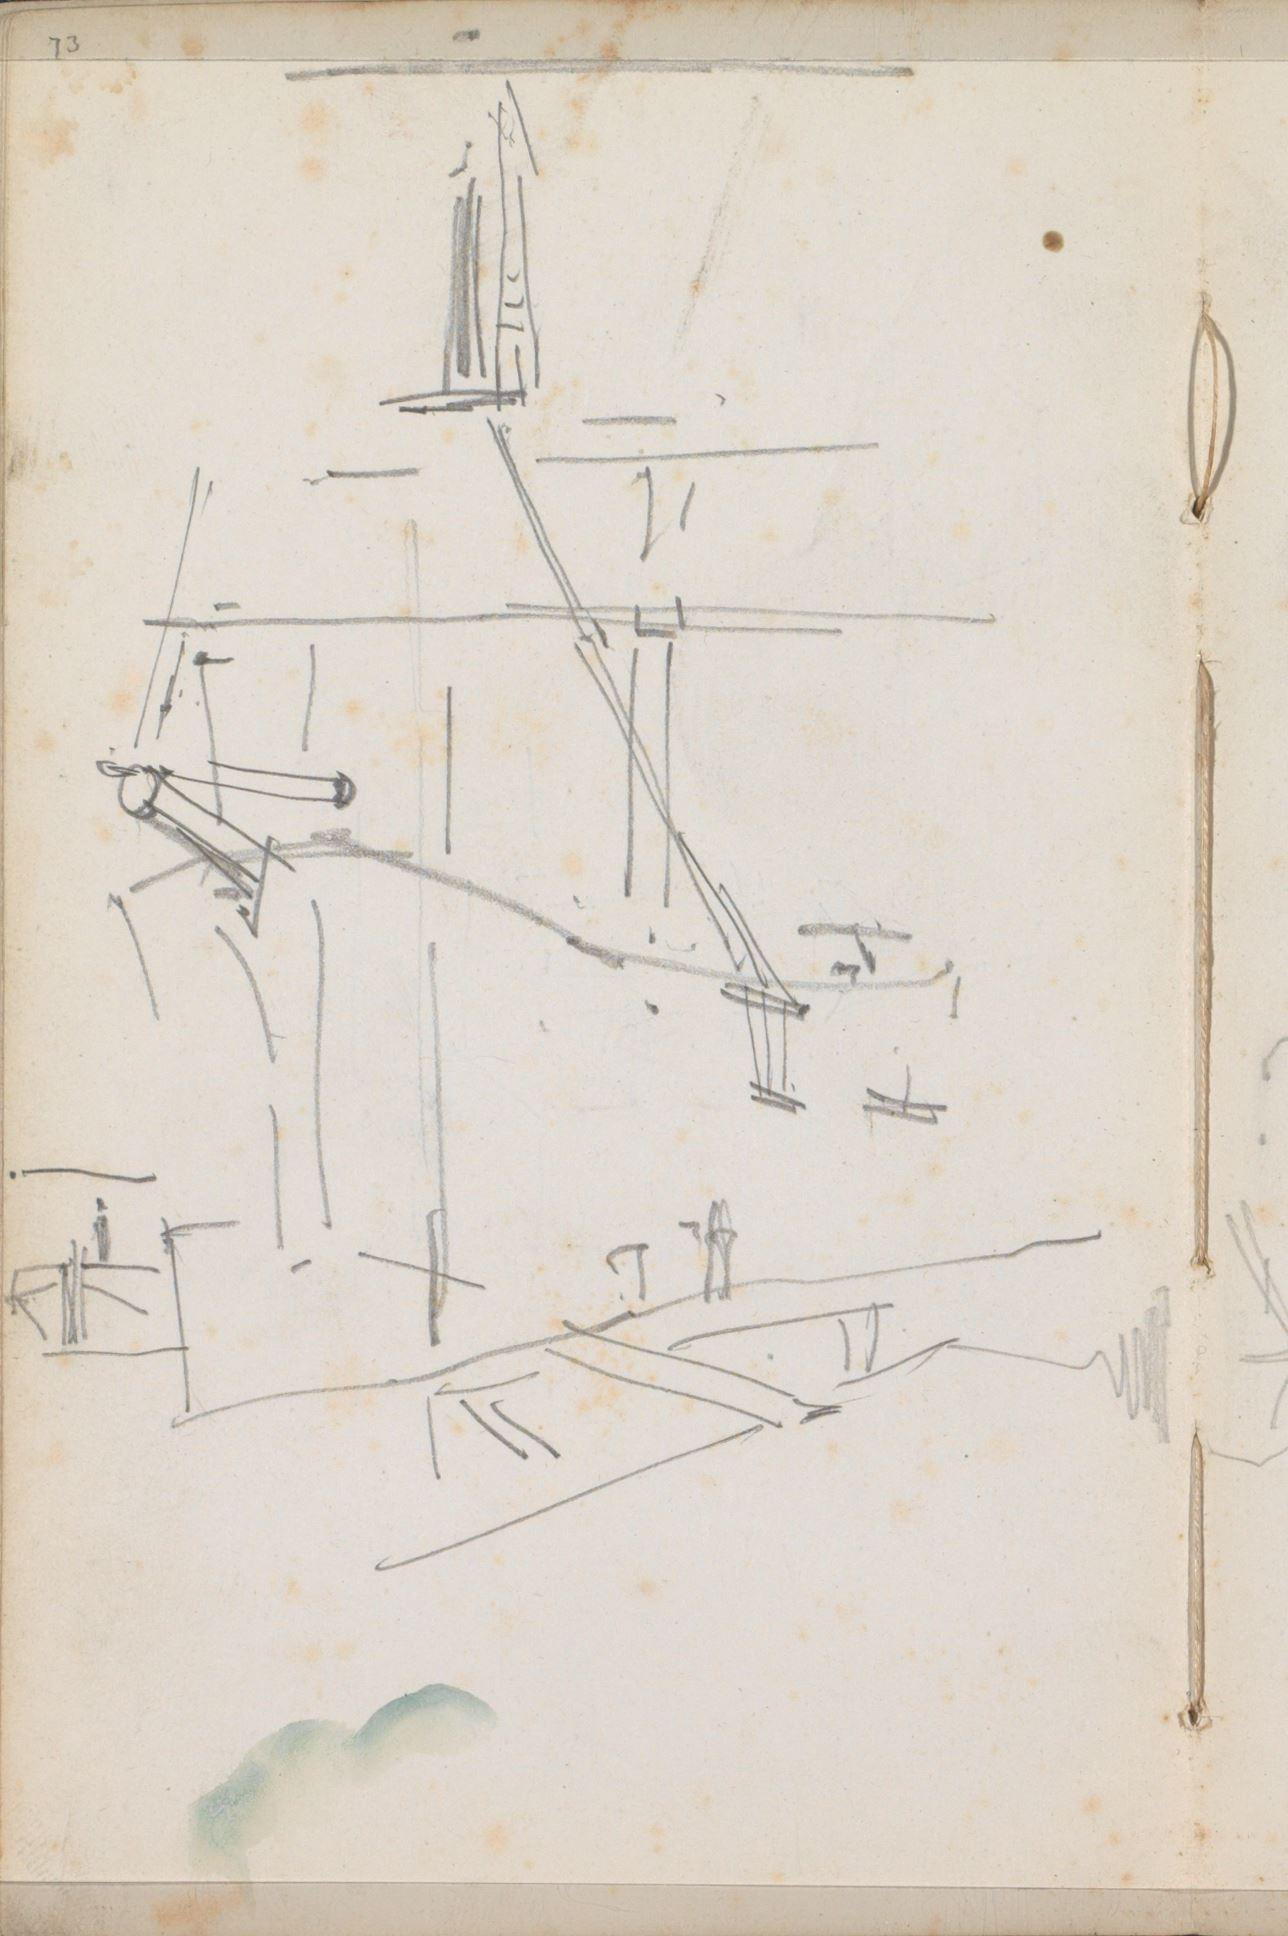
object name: sketchbook leaf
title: Schip in een haven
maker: george hendrik breitner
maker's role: draughtsman, painter, print maker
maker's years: 1857-1923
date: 1880-1882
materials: paper, pencil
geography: south holland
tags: harbour, ships (in general)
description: Pagina 73 uit een schetsboek met 72 bladen.